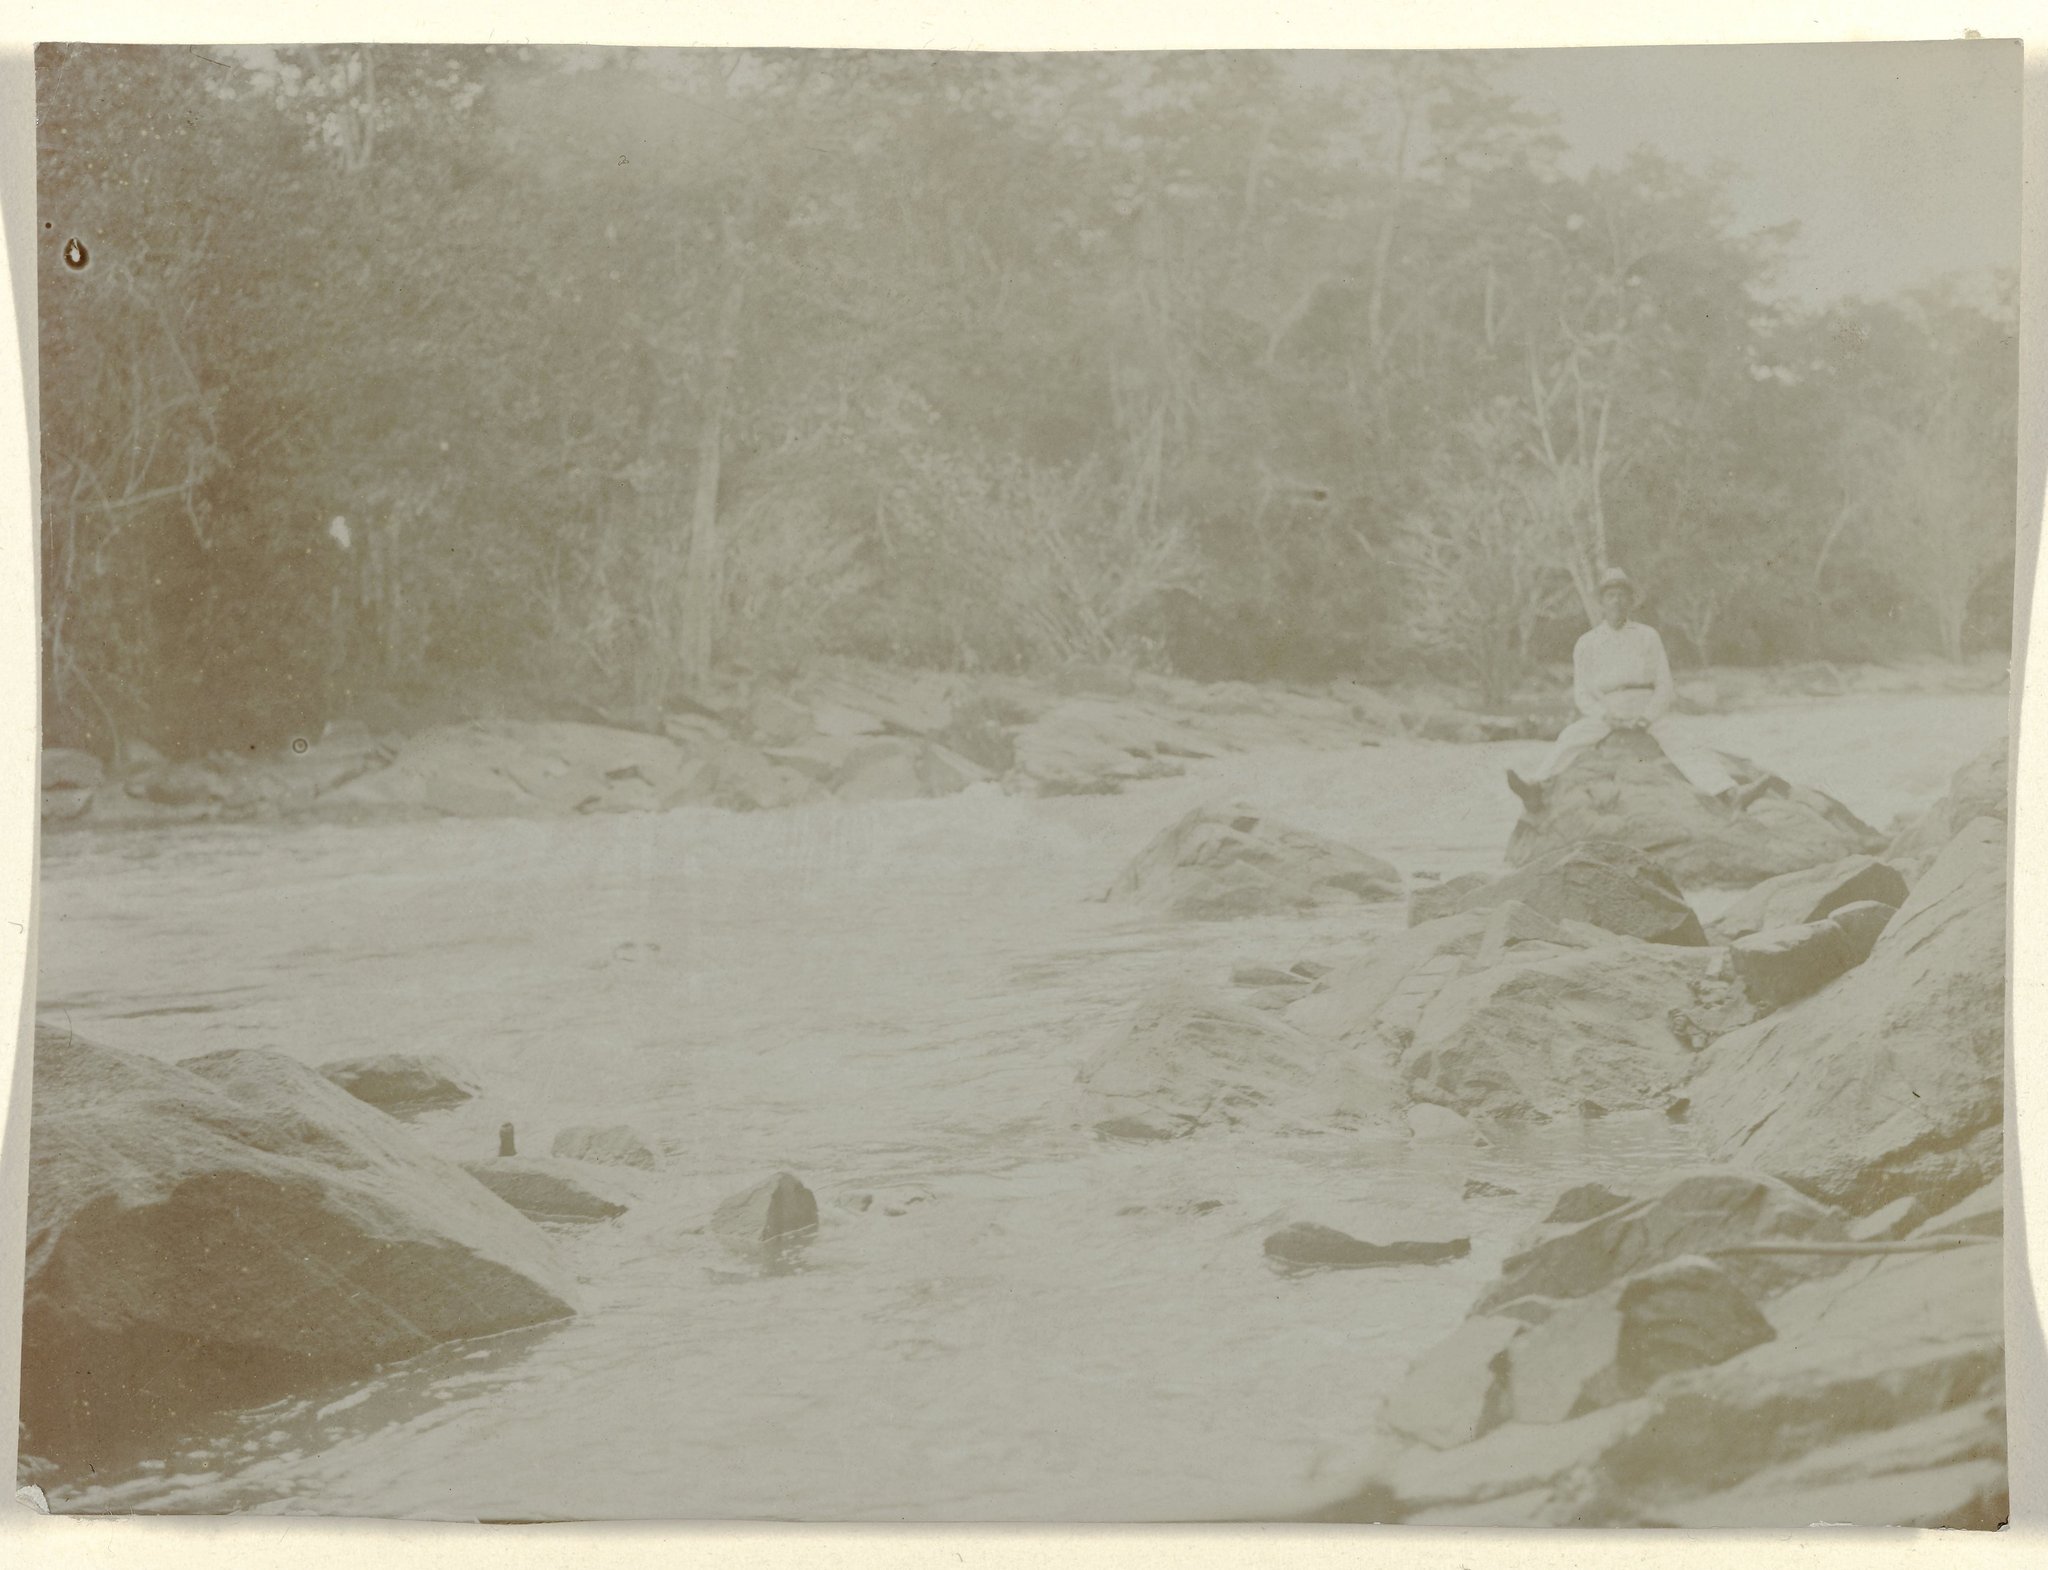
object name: photograph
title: Opzichter Overloon aan de Sarakreek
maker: jacob evert wesenhagen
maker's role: amateurfotograaf, arts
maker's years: 1862-1924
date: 1905-1910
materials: photographic support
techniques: photography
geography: suriname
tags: landscapes in tropical and sub-tropical regions, suriname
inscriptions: annotation: ‘val v/d Sarakreek (Godosingi) / opzichter Overloon’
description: Opzichter Overloon poseert op een rots bij de watervallen in de Sarakreek. Waarschijnlijk bij de aanleg van de Lawaspoorweg in Suriname in de jaren 1903-1912. Onderdeel van een groep objecten afkomstig van de familie Wesenhagen in Suriname.